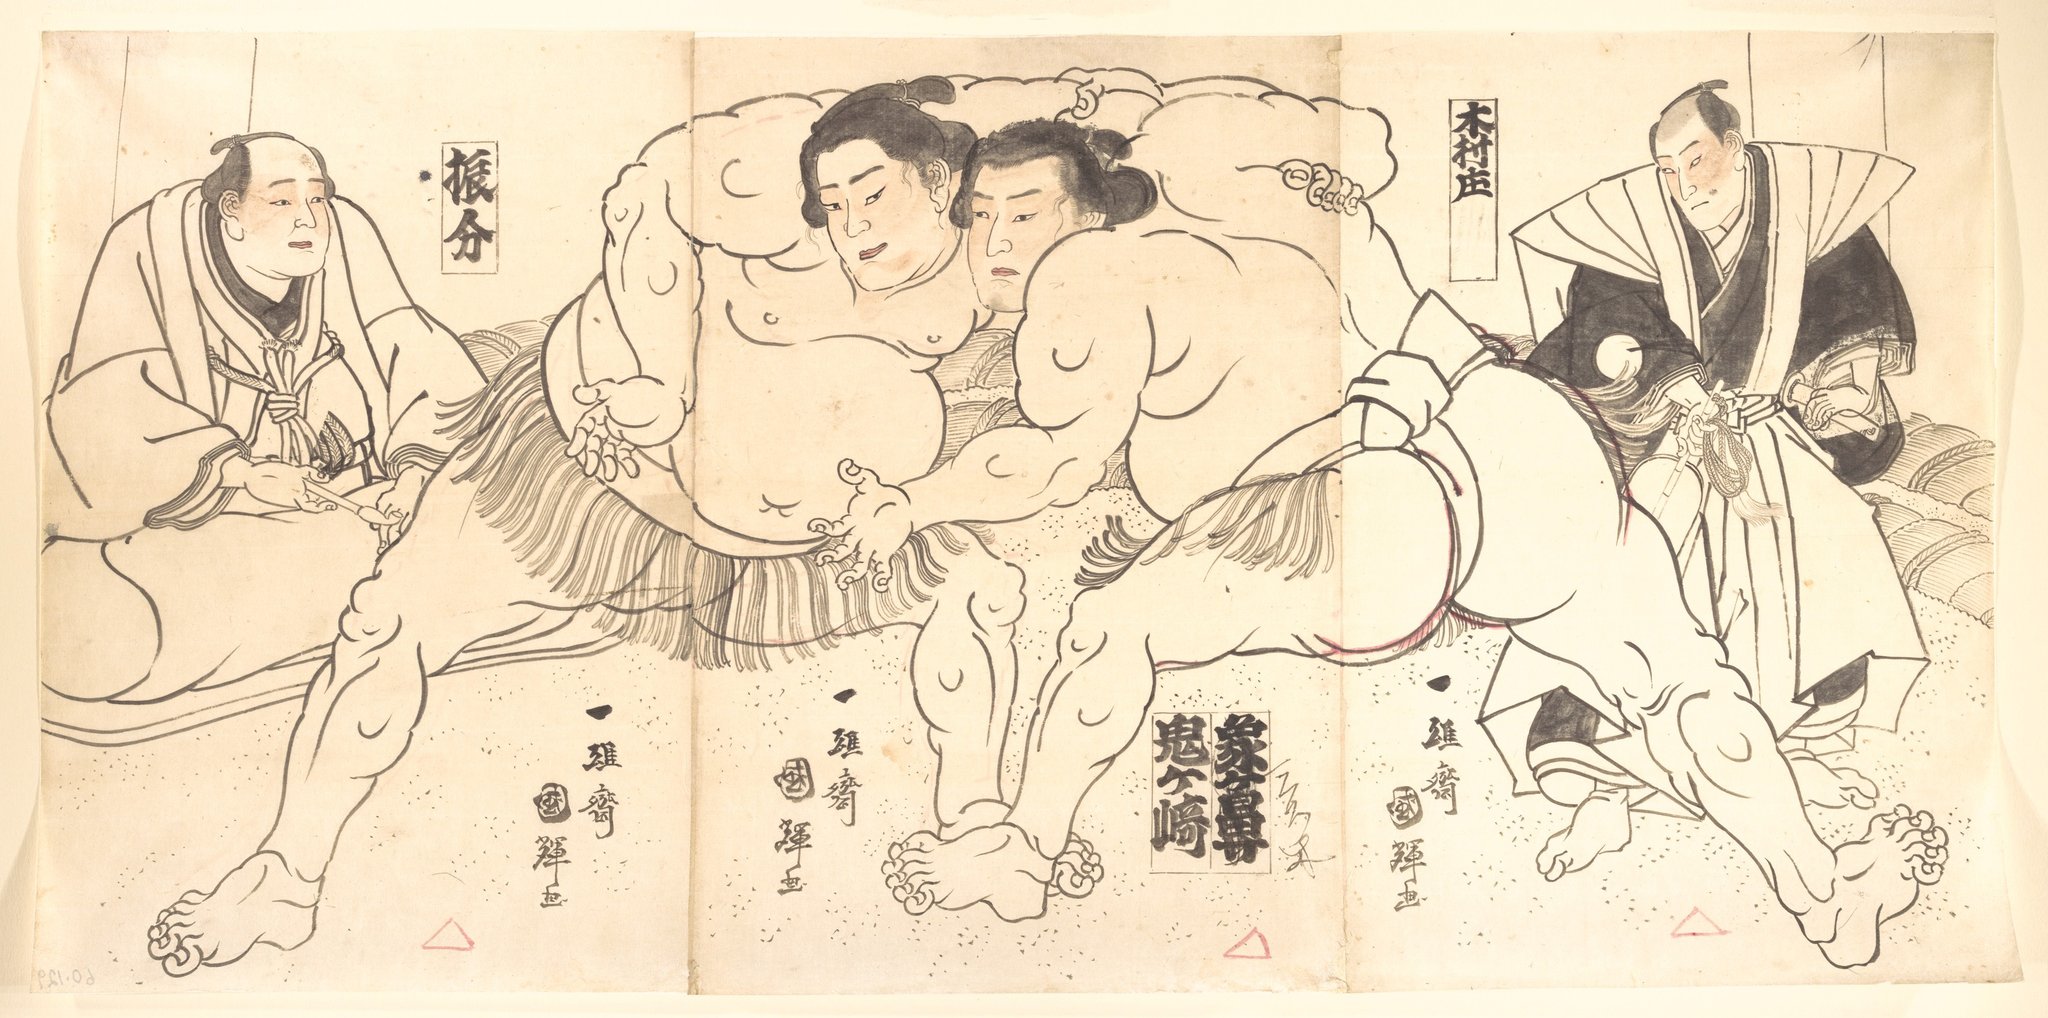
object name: painting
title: Sumo Wrestling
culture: japanese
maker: utagawa kuniteru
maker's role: artist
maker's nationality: japanese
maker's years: 1830-1874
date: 1801-1900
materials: ink, paper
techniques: painting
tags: men,wrestling